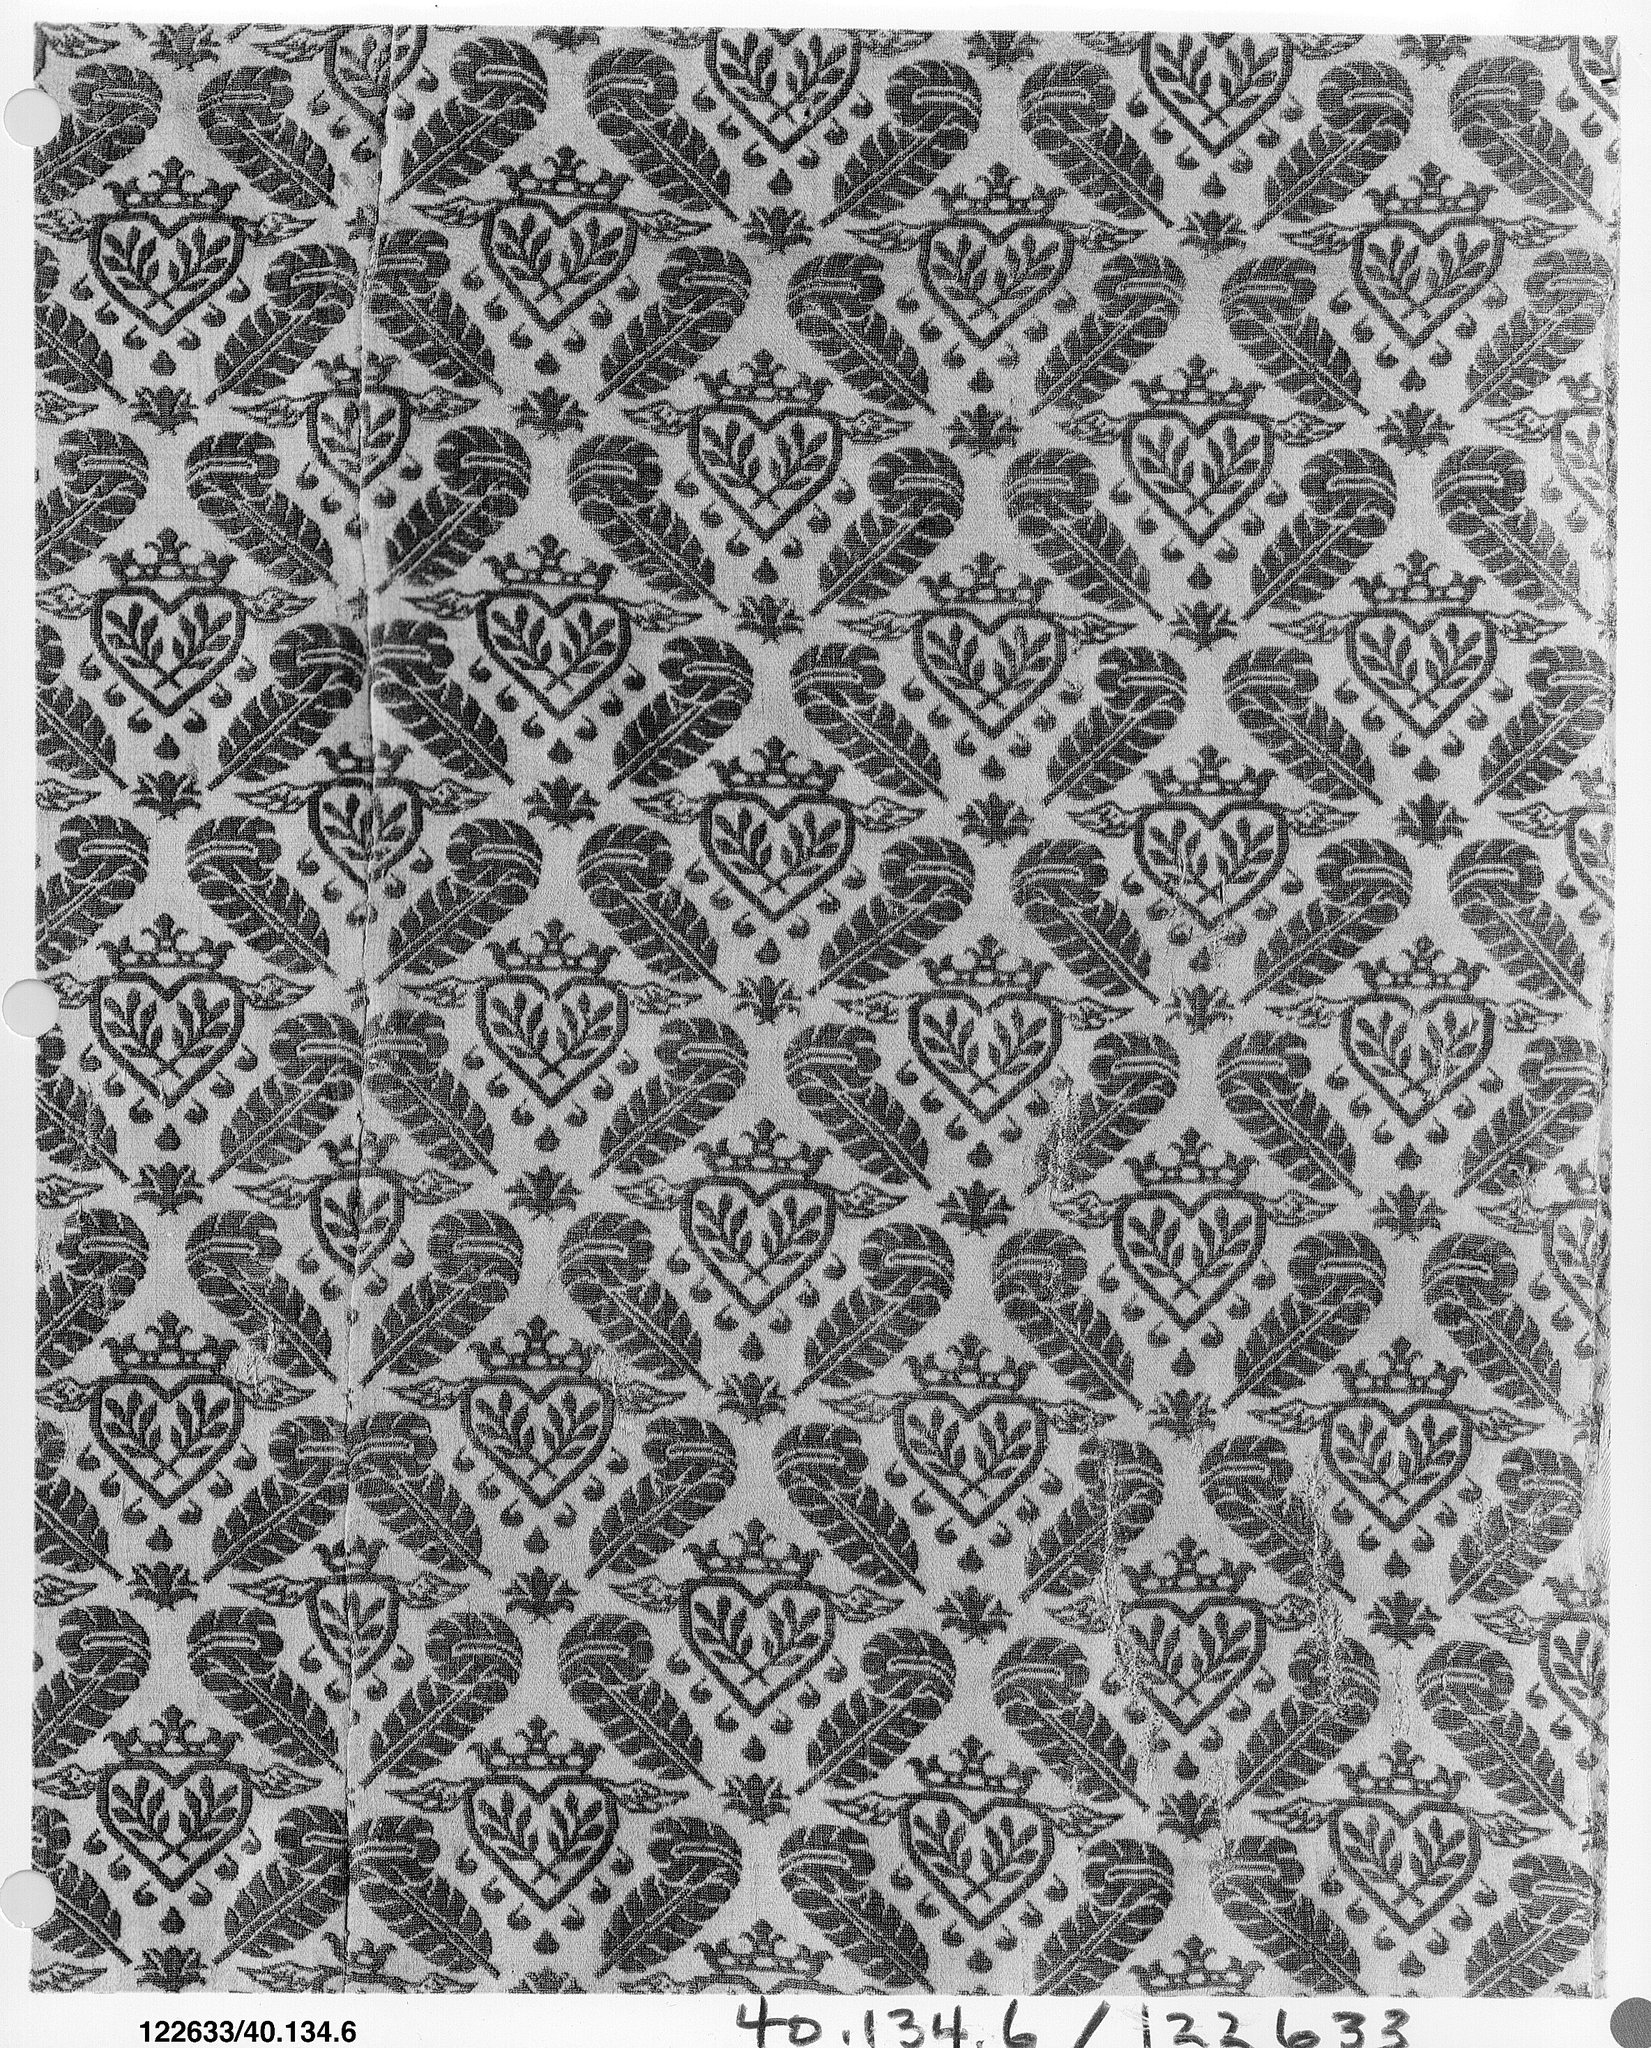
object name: piece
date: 1601-1633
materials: silk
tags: leaves